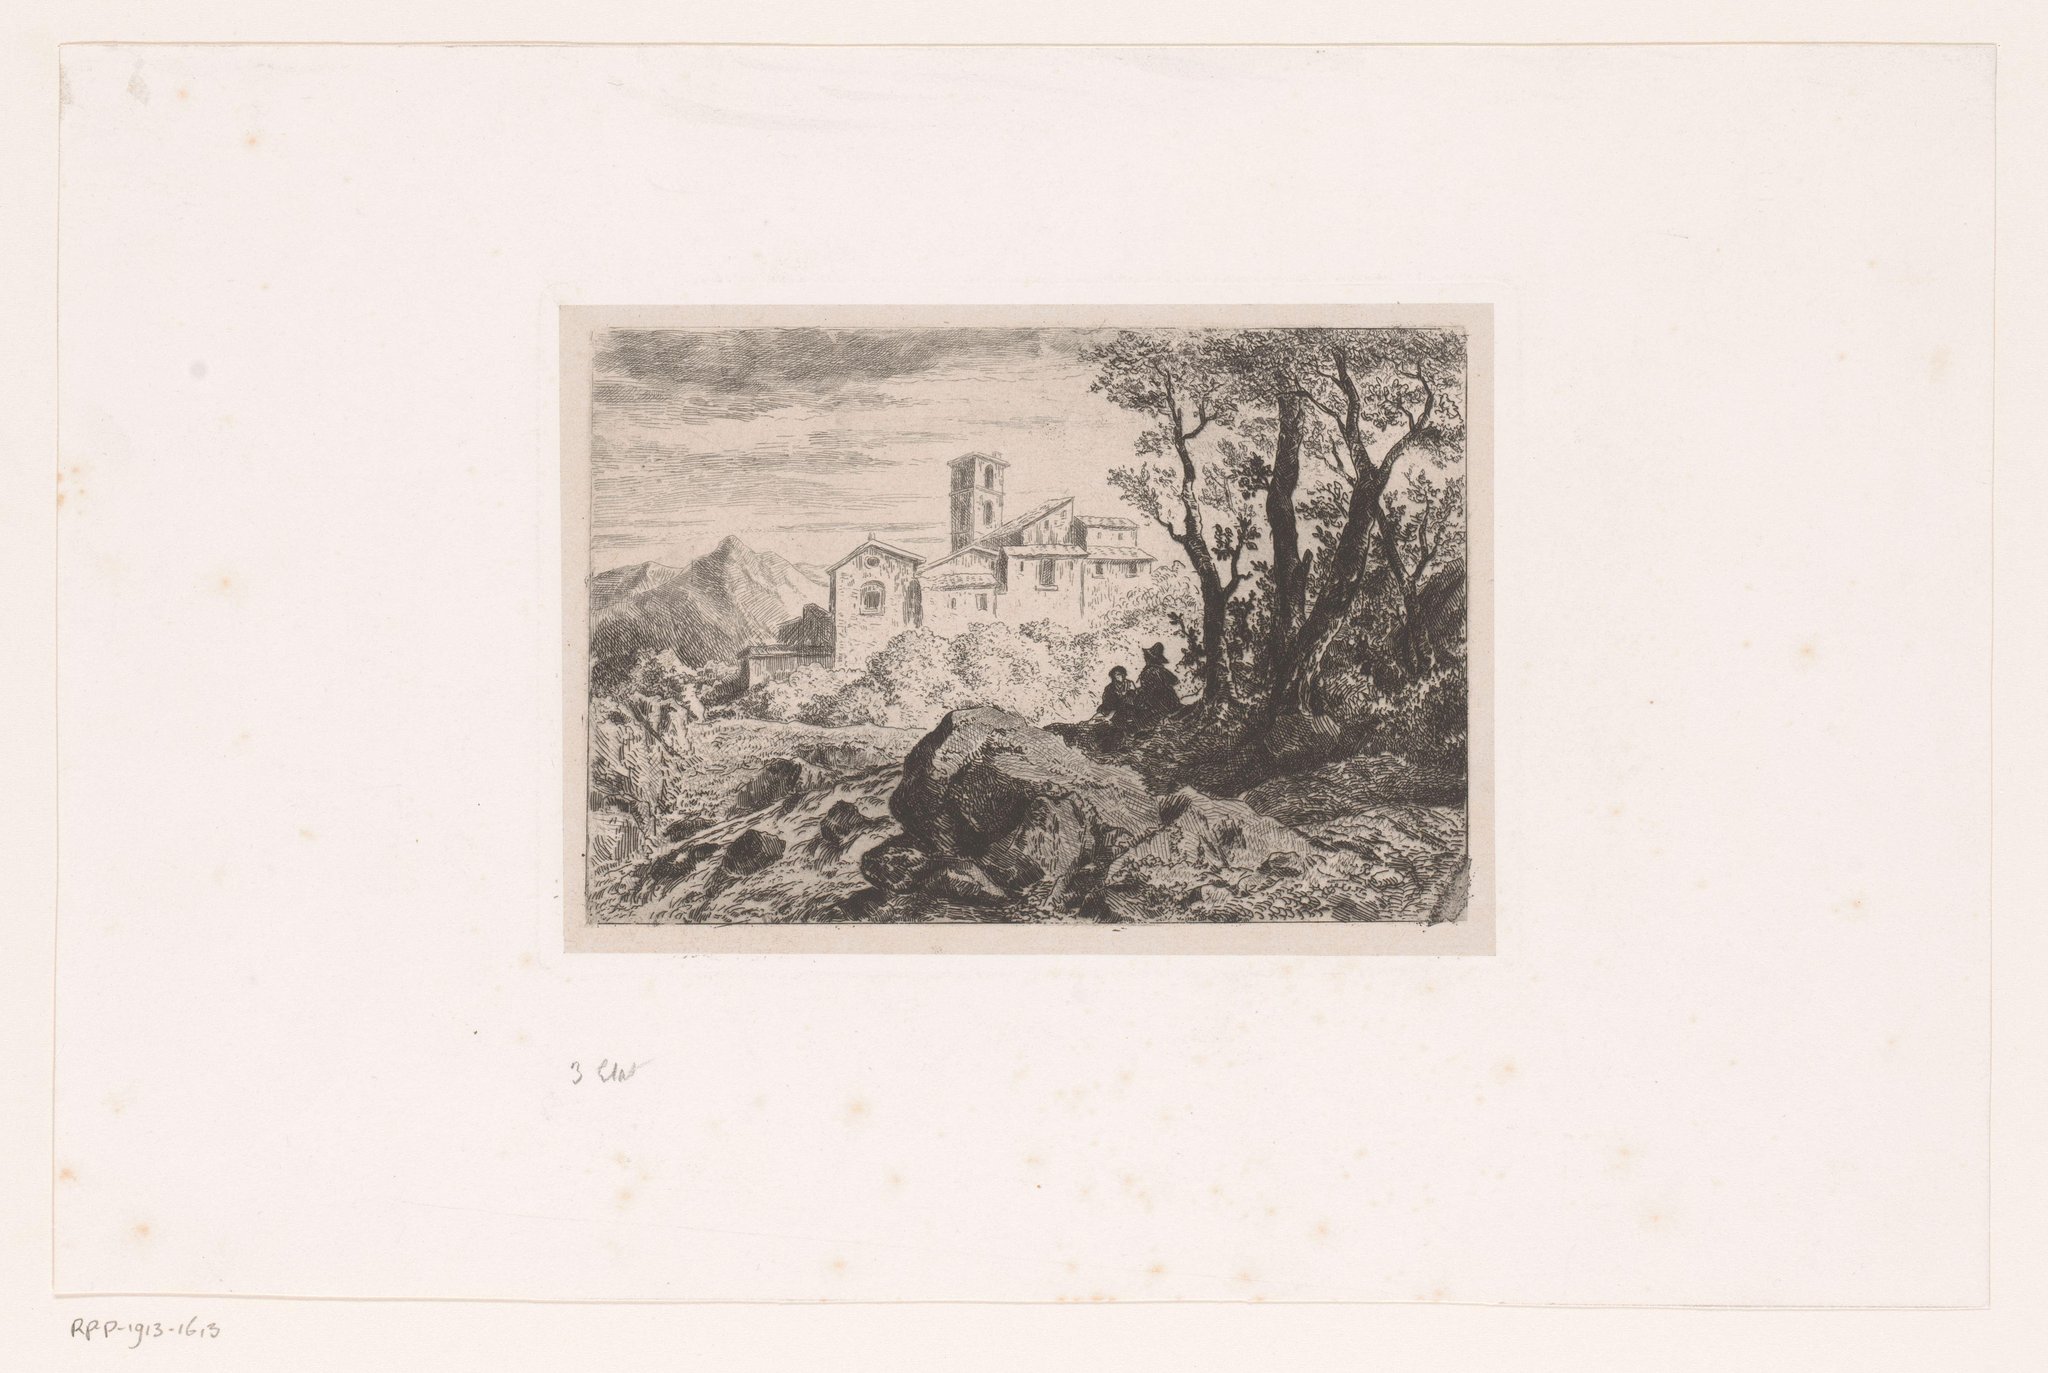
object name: print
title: Italiaans landschap met twee figuren op een rots en een klooster op de achtergrond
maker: joseph meganck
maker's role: print maker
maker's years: 1807-1891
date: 1817-1888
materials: paper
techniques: etching, intaglio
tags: abbey, monastery, convent ~ roman catholic church, landscapes (+ landscape with figures, staffage), rocks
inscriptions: collector's mark: Lugt 2228, inscription: ‘3 etat’